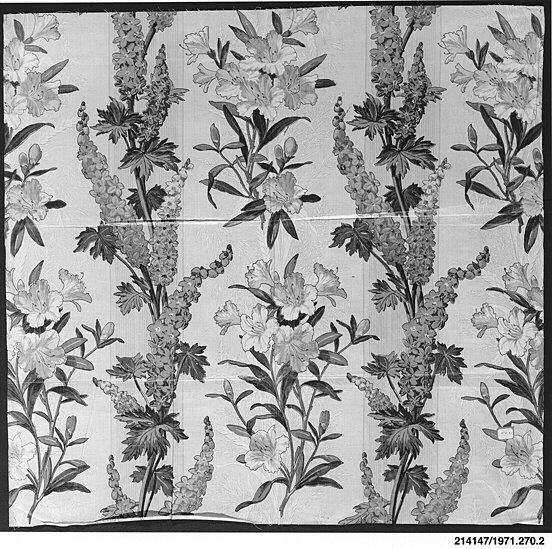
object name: sample book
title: Textile Sample Book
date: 1840-1860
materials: cotton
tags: flowers